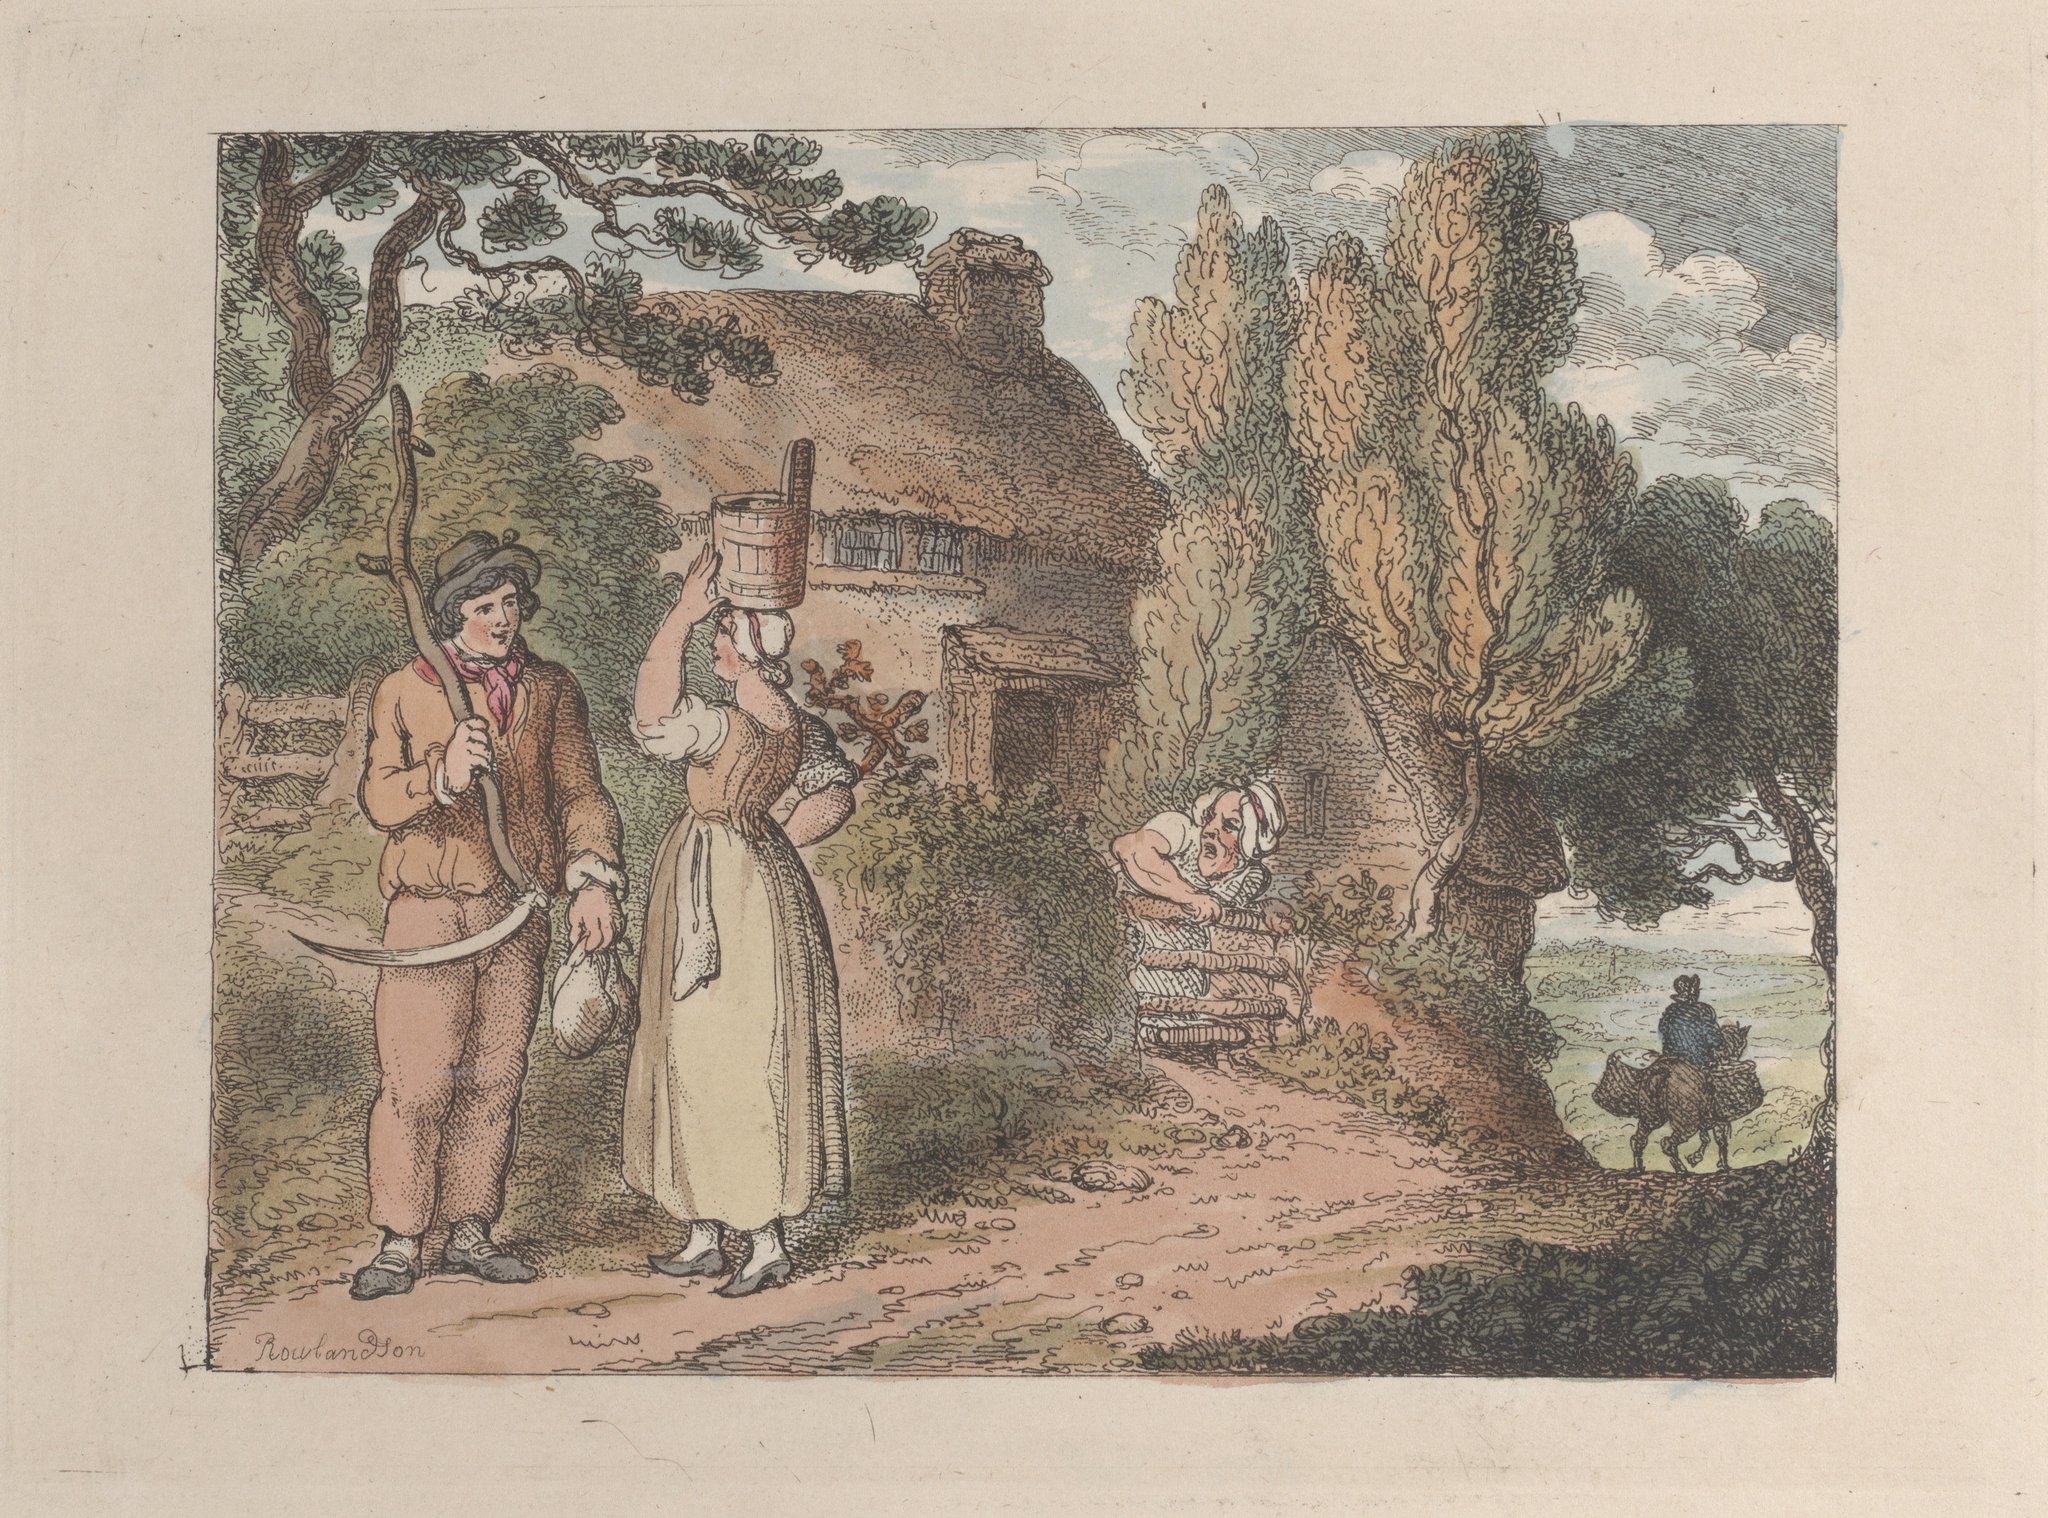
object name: print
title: Cornwall, An Overlooker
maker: thomas rowlandson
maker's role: artist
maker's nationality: british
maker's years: 1757-1827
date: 1812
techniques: etching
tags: houses,men,women